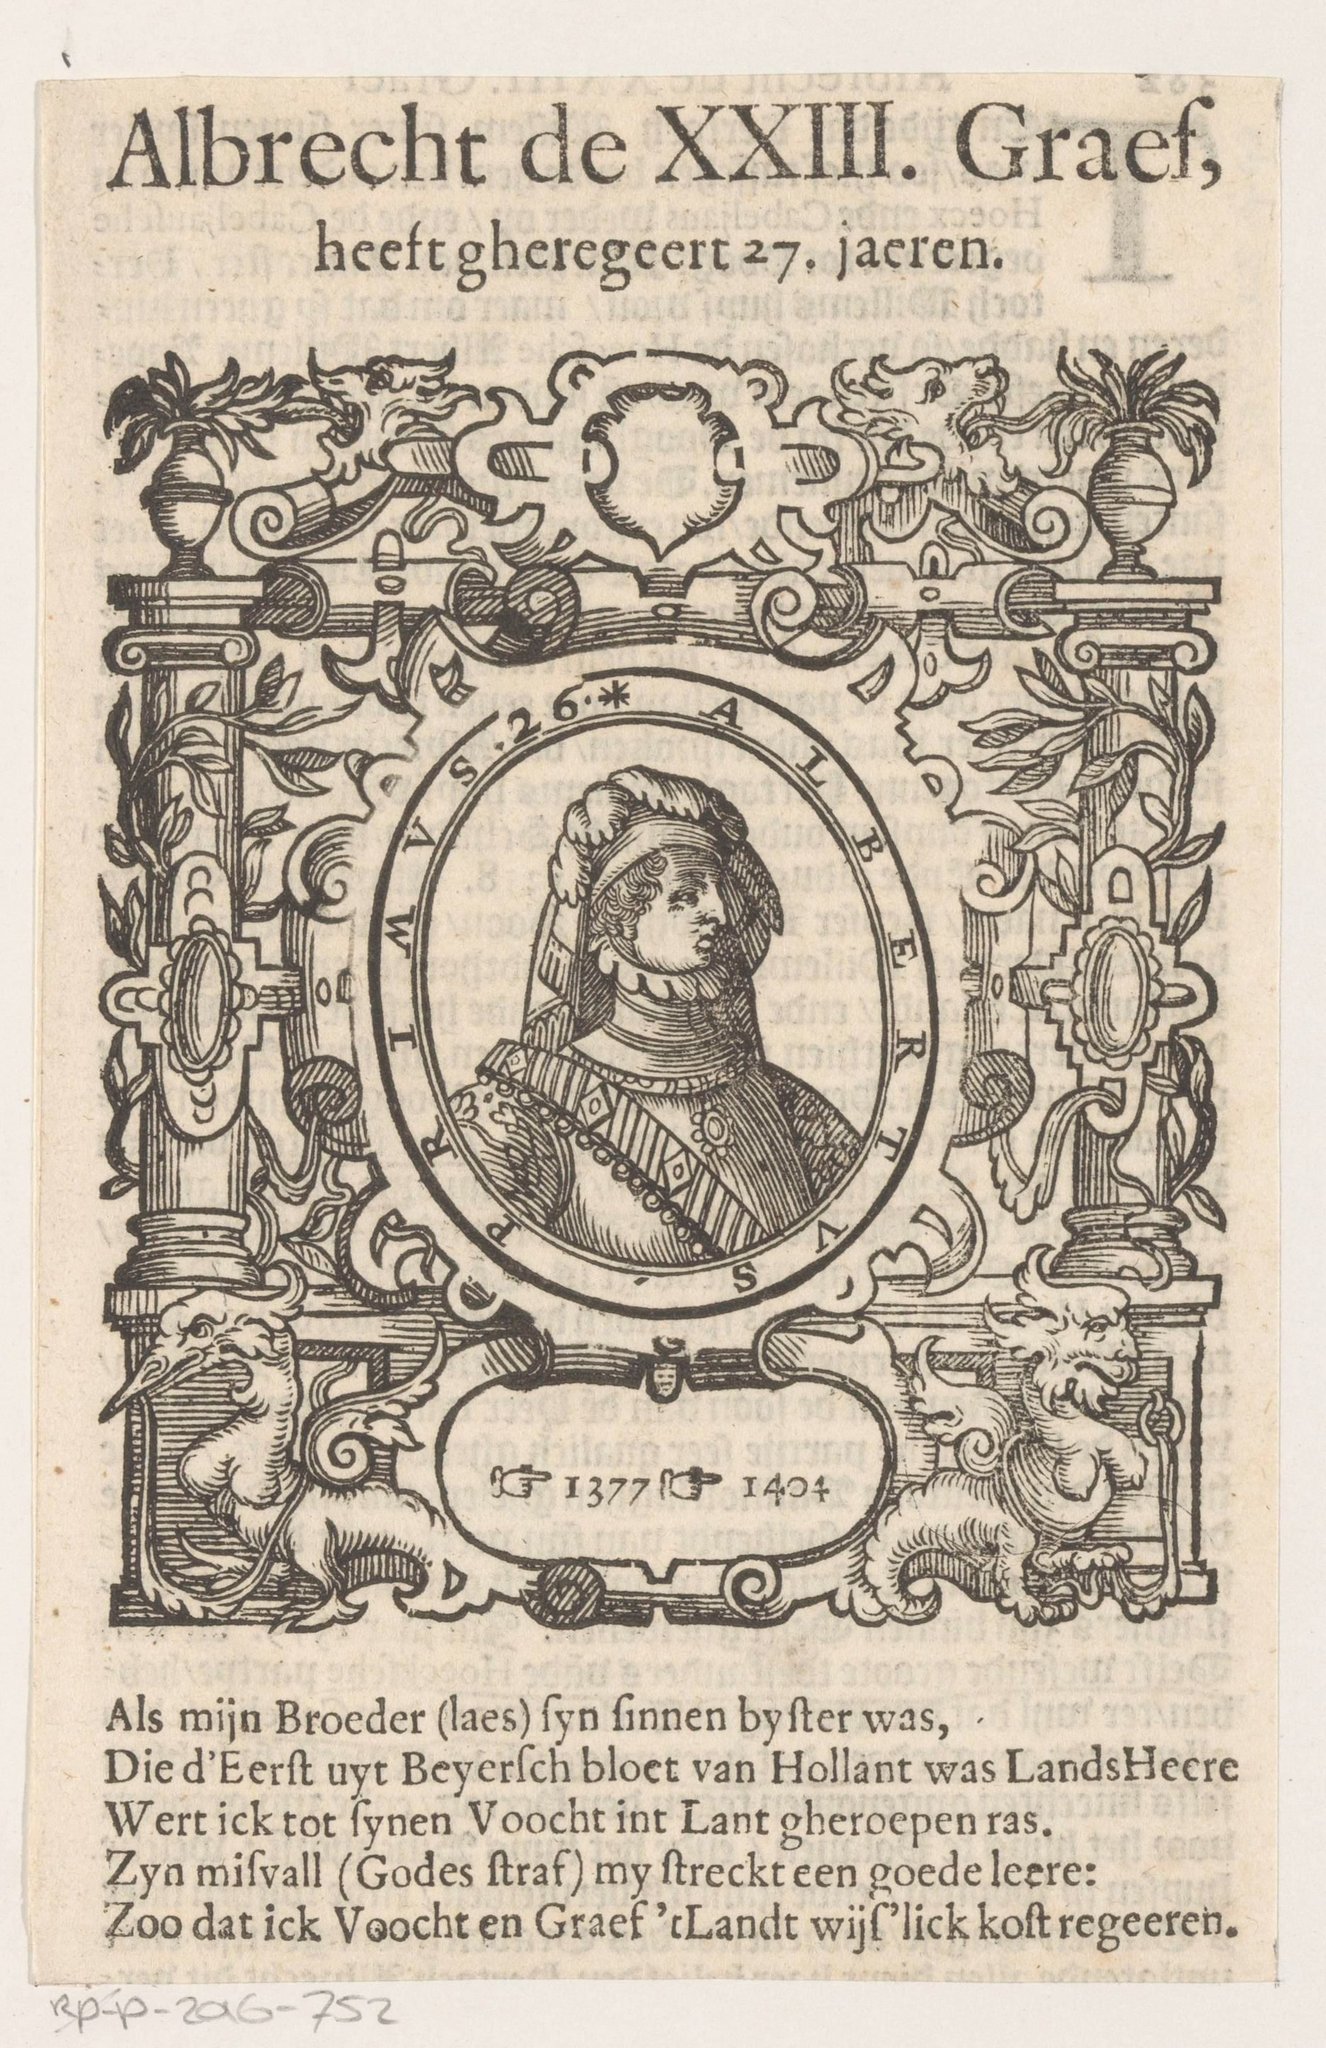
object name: print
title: Portret van Albrecht van Beieren, graaf van Holland, Henegouwen en Zeeland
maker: Anonymous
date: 1600-1699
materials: paper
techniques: letterpress printing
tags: the hague, duke of bavaria albert i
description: Portret van Albrecht van Beieren in een ovale omlijsting met randschrift. In een kader zijn regeringsperiode. Geheel in een geornamenteerde, rechthoekige omlijsting met een aantal allegorische objecten en dieren.